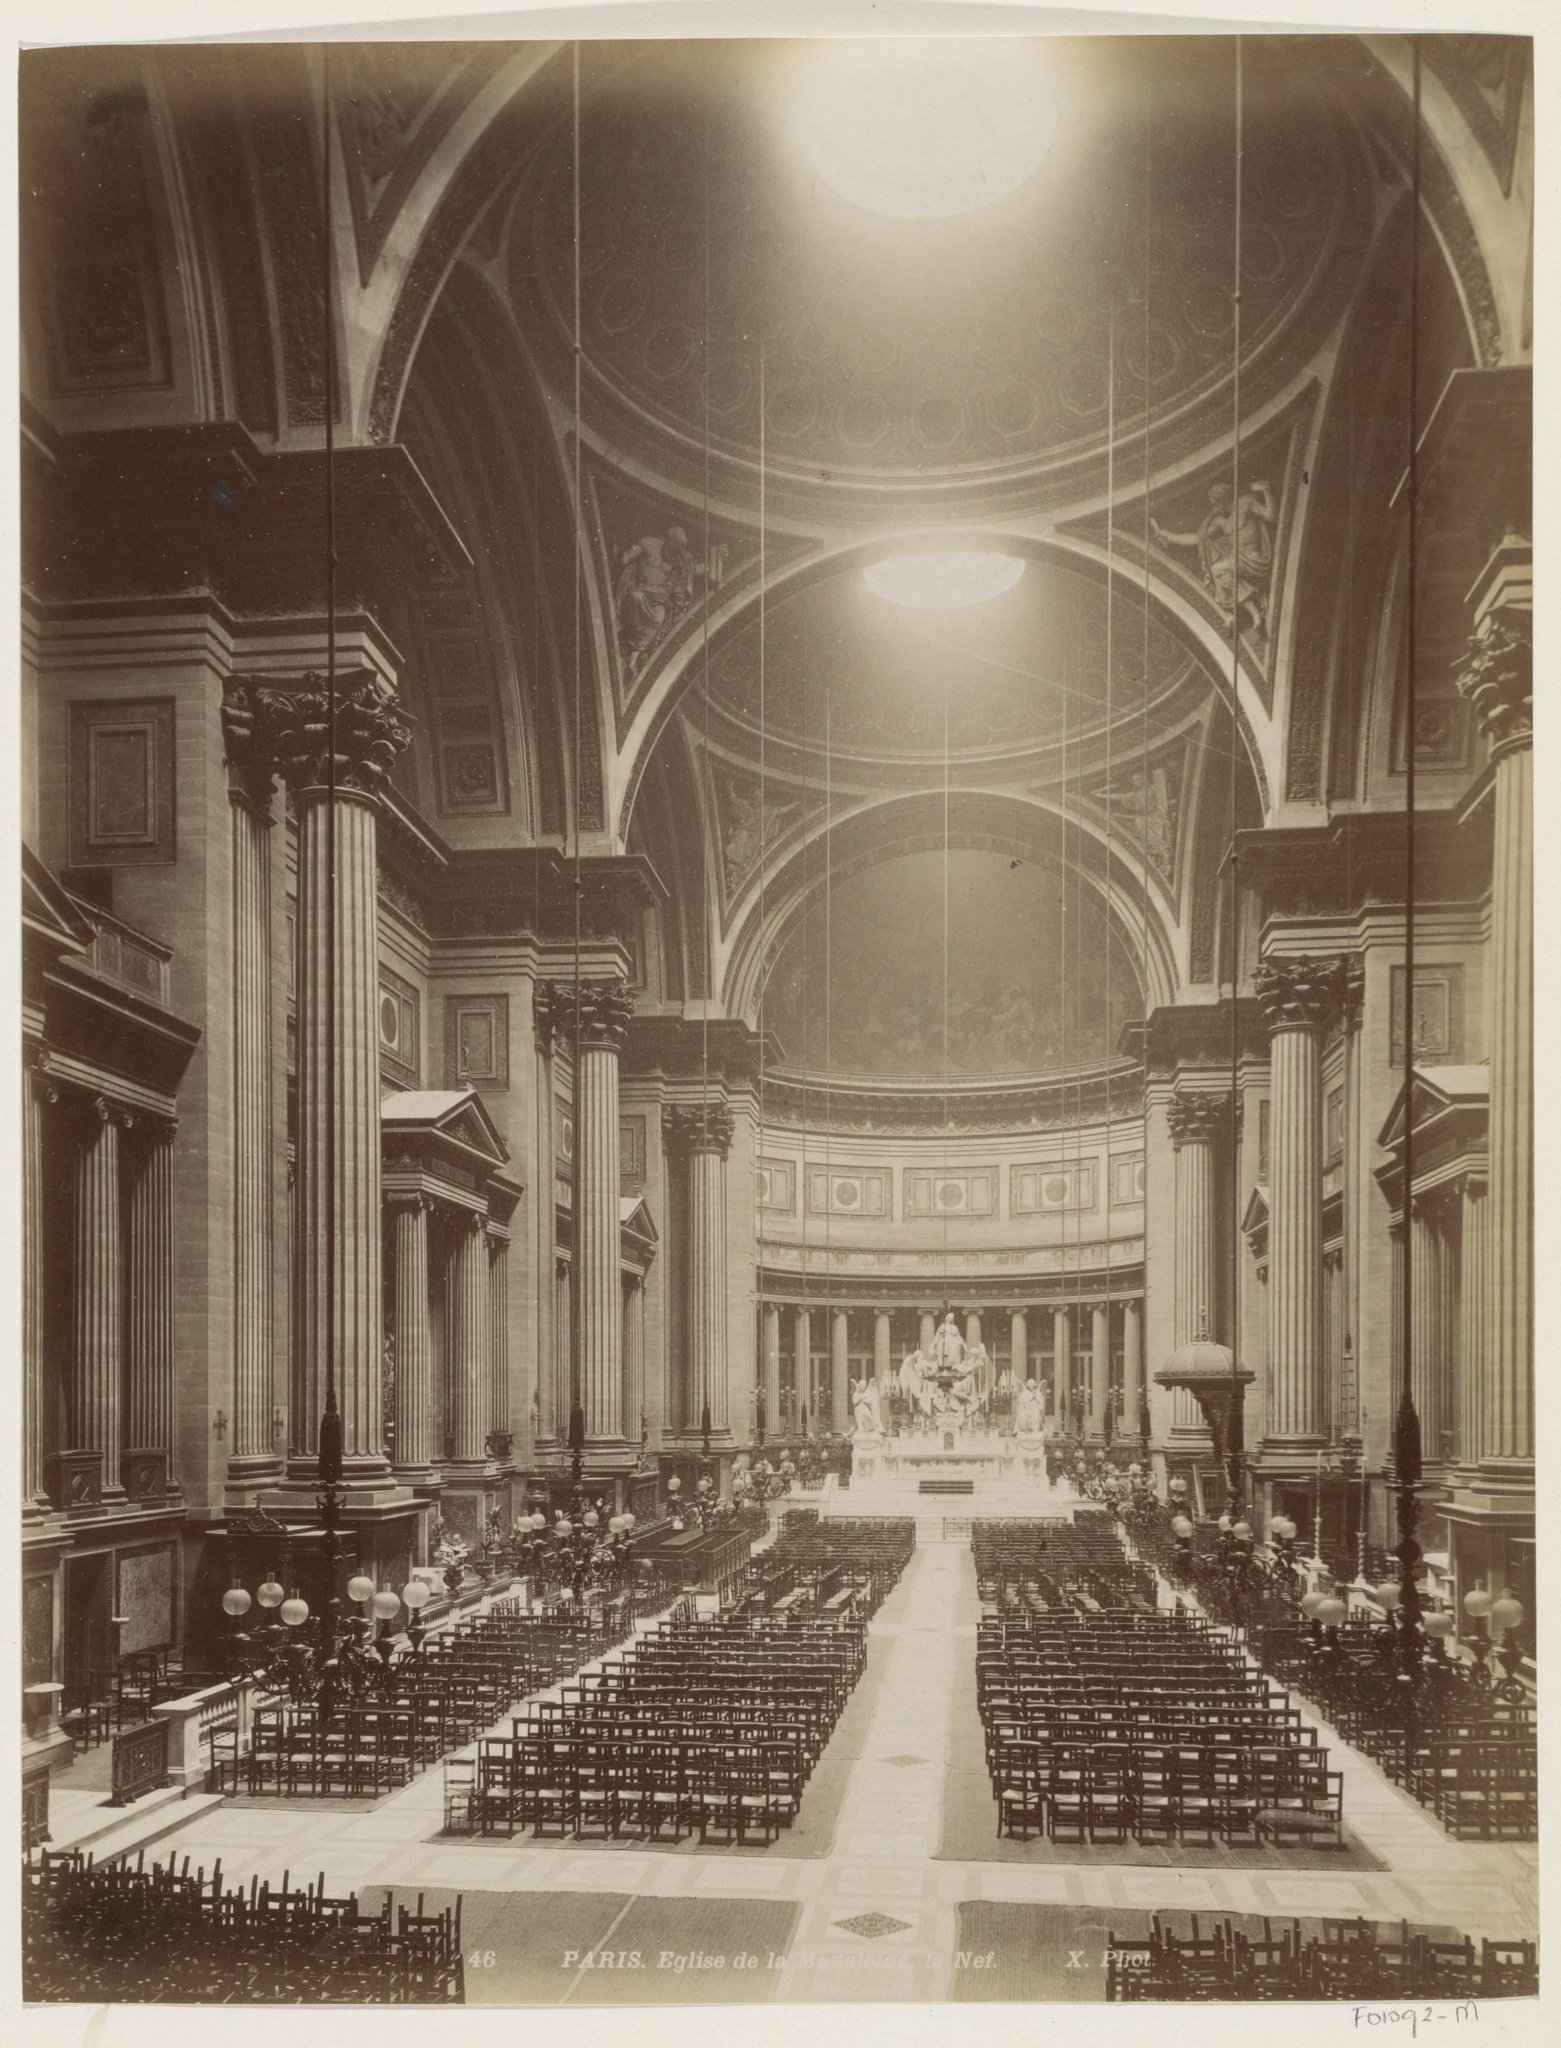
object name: photograph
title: PARIS. Église de la Madeleine, la Nef.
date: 1880-1900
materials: cardboard, paper, photographic support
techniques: albumen print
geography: paris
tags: parts of church interior: nave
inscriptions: negative number: ‘46’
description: Onderdeel van Reisalbum met foto's van bezienswaardigheden in België en Frankrijk.